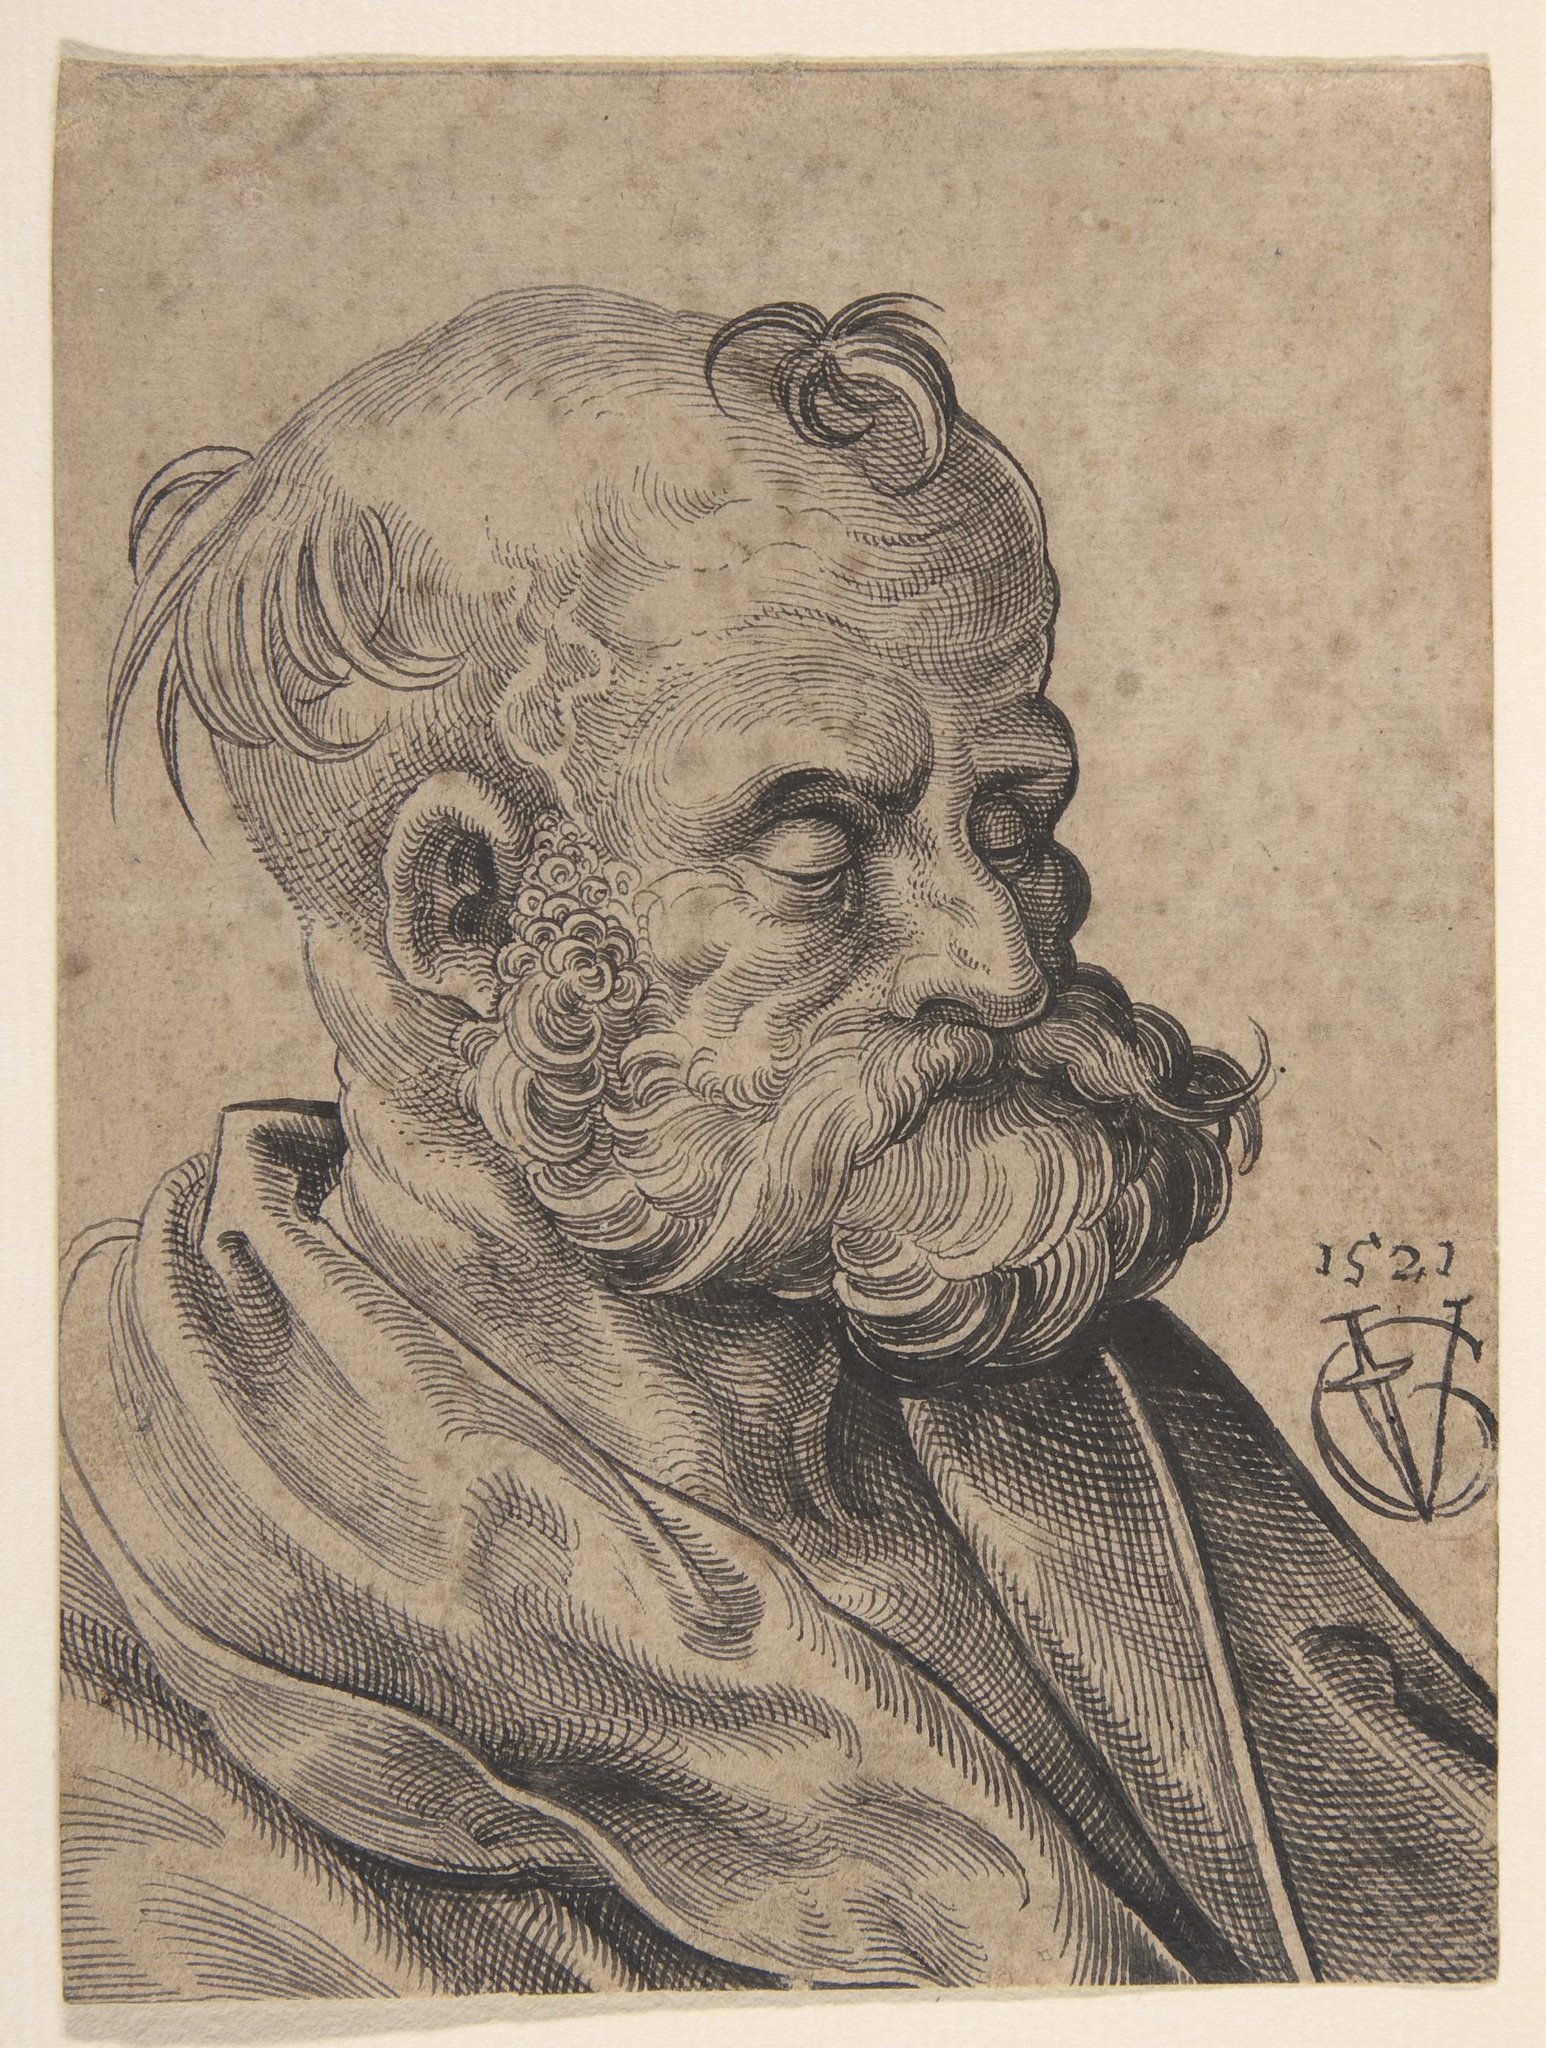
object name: drawing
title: Bust of a Bearded Old Man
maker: urs graf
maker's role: artist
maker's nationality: swiss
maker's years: 1485-1527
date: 1521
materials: ink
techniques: pen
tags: men